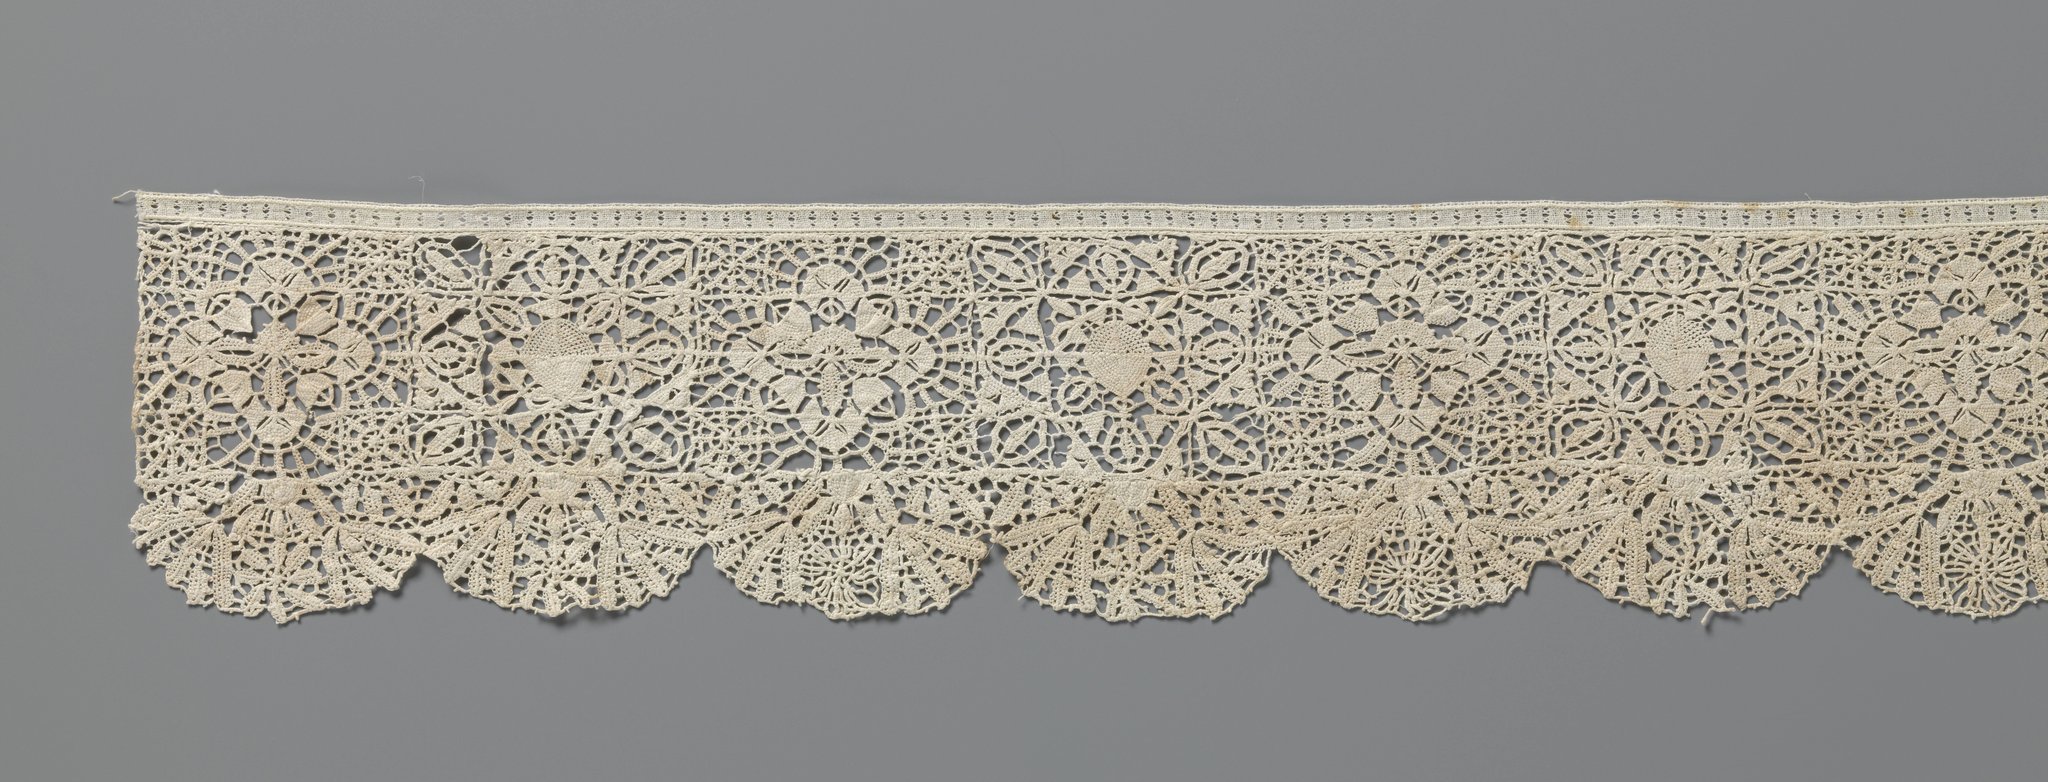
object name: strip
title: Strook naaldkant met ruit en rozet in vierkanten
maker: Anonymous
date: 1620-1630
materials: linen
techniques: needle lace, reticella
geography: italy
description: Strook naturelkleurig naaldkant, reticella. Een zich herhalend patroon van een vierkant, afwisselend met een ruit of rozet, die uit 4x4 kleine vierkantjes is opgebouwd. Langs de onderrand onder elk groot vierkant een halfronde schulp met wisselende vulling tussen twee klokvormige, hangende bloemen. De bovenzijde is afgezet met een geweven rand, dit is vermoedelijk van latere datum dan het kant.